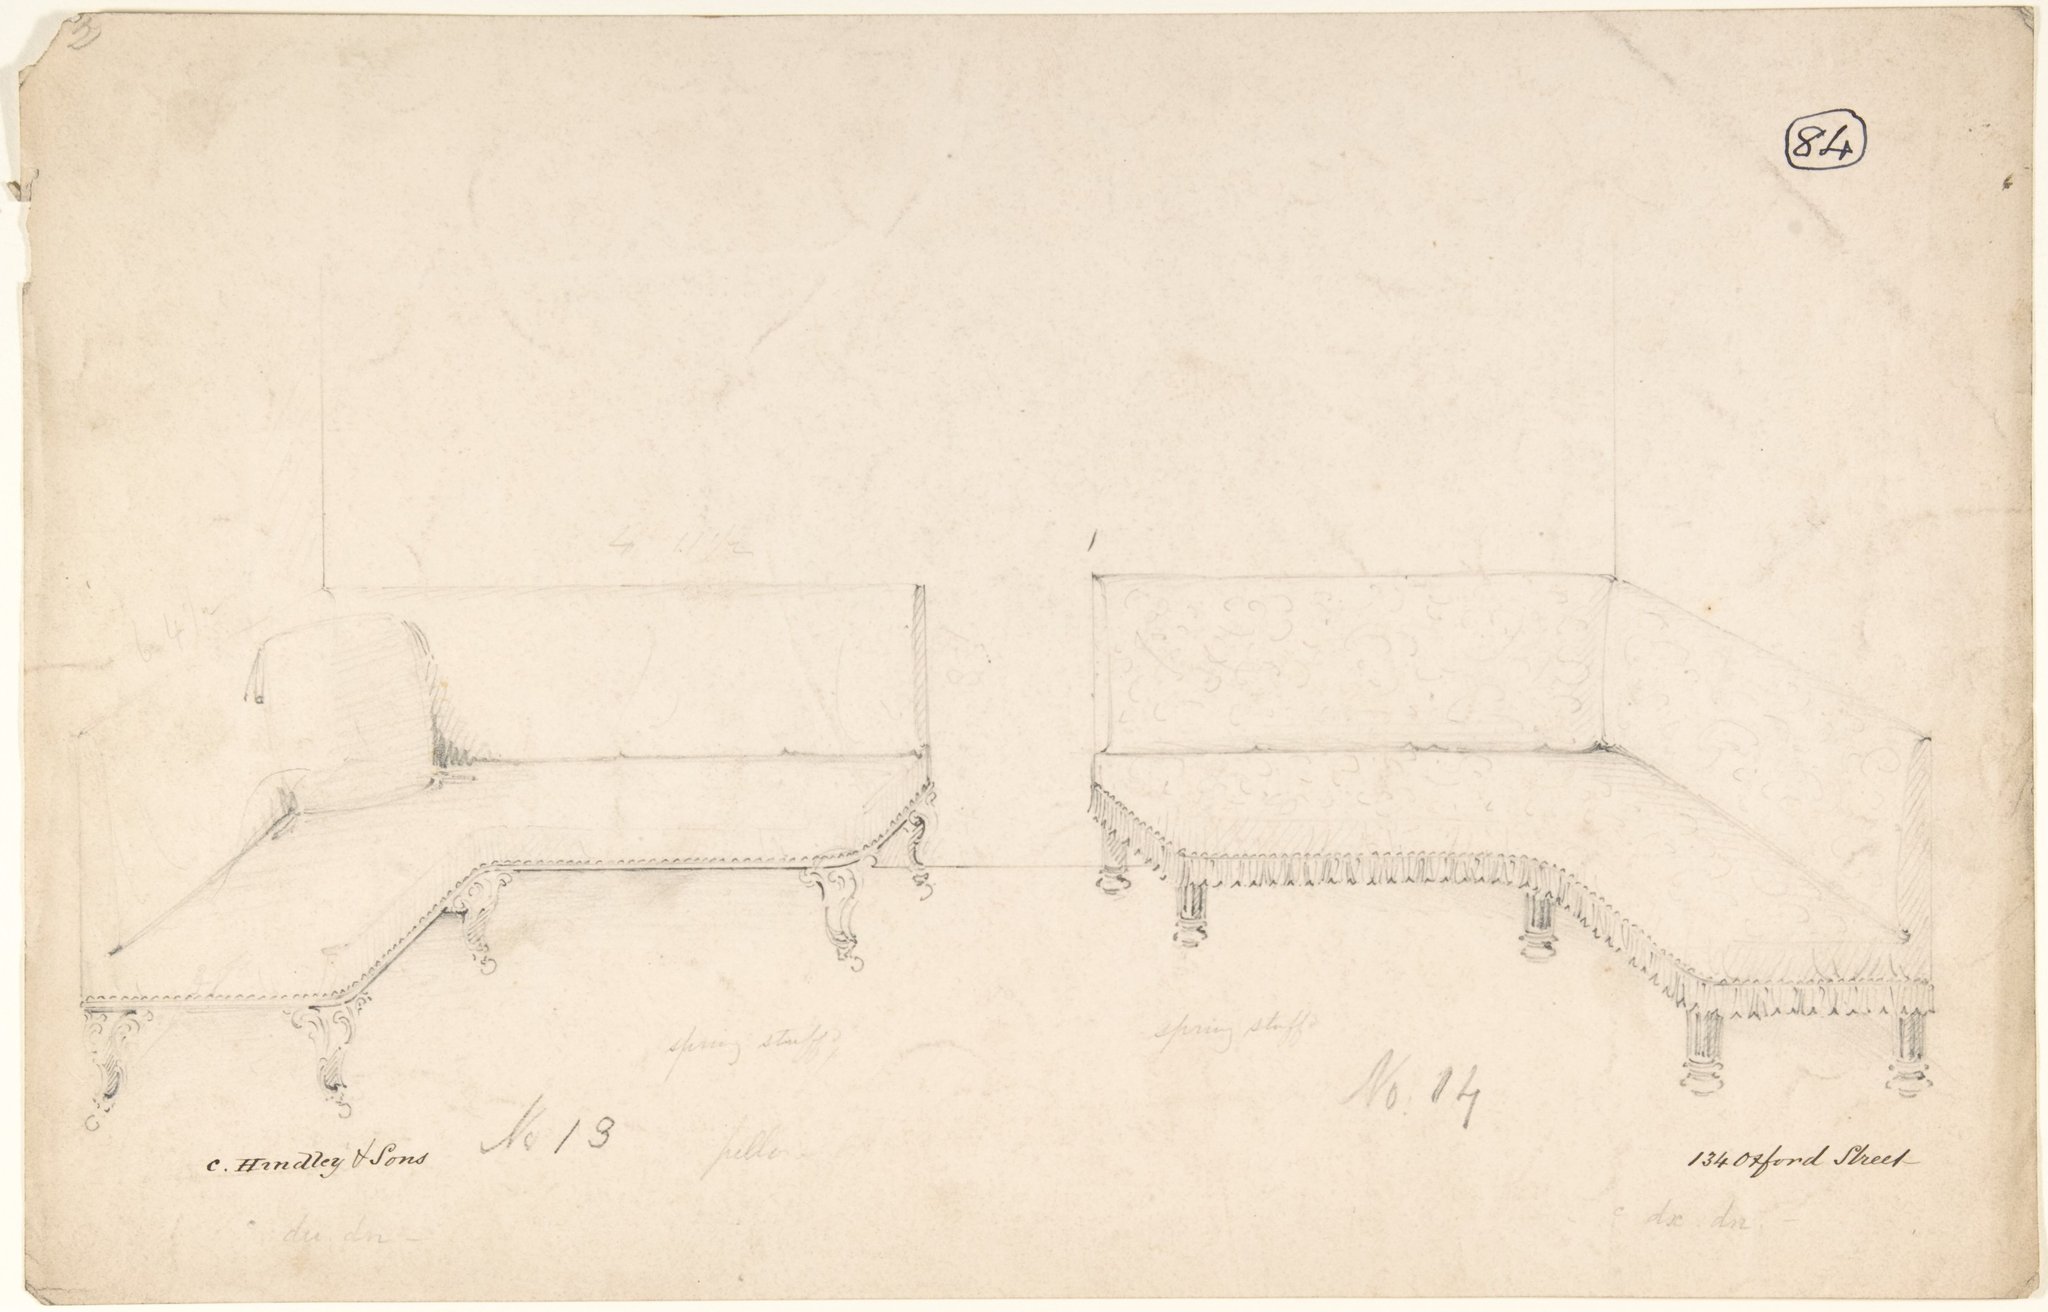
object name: drawing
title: Designs for Two Corner Couches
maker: charles hindley and sons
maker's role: artist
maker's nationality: british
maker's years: 1841-1917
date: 1841-1884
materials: graphite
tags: couches